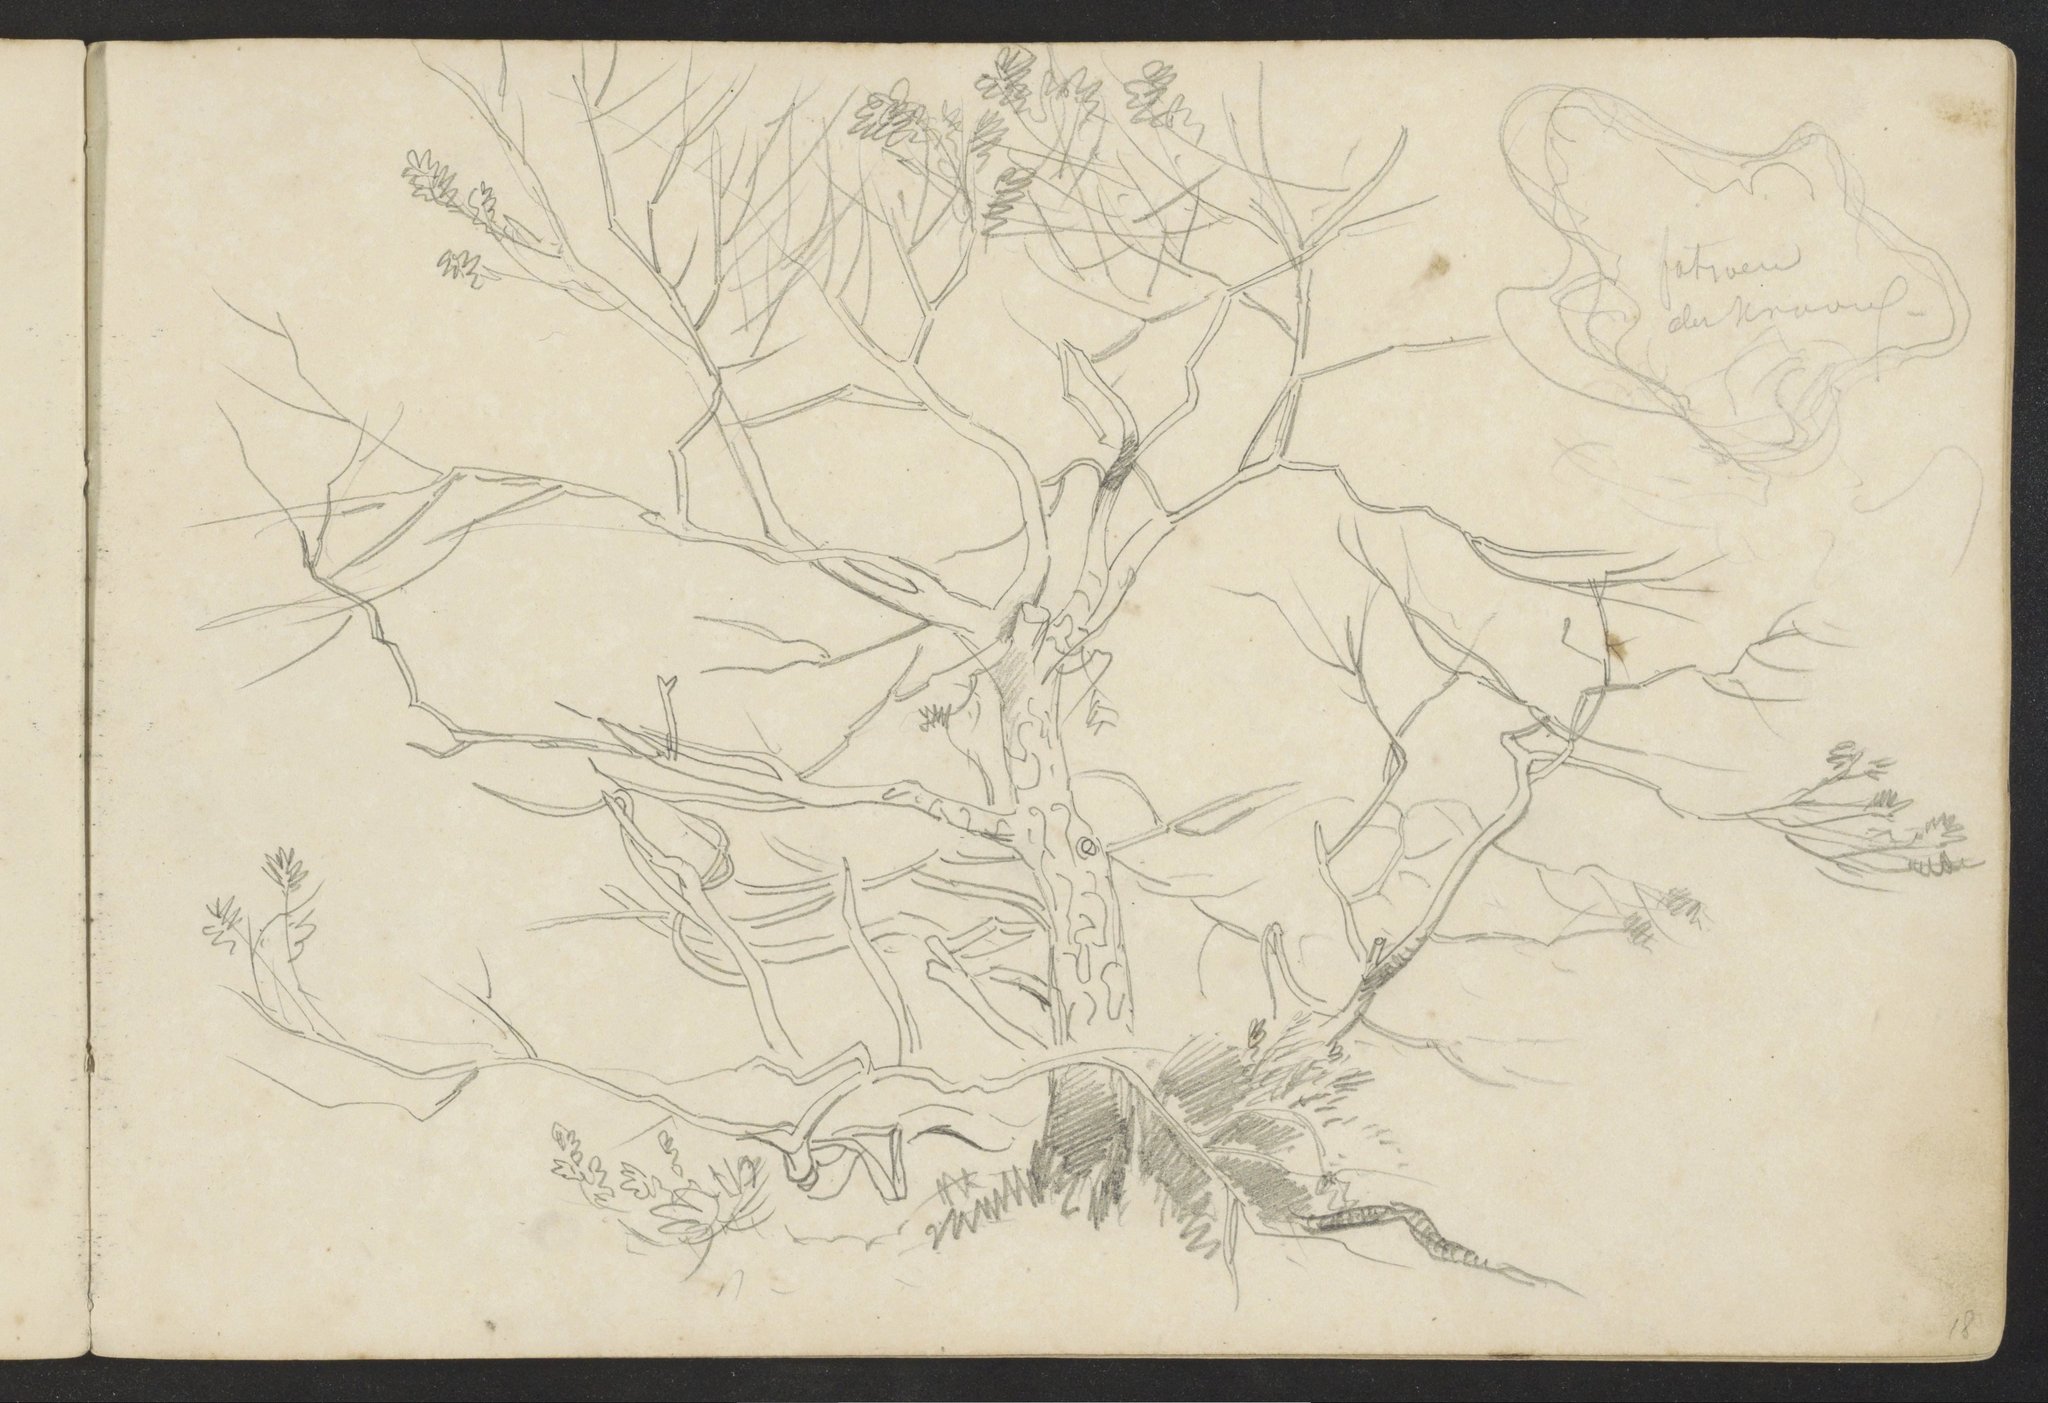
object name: sketchbook leaf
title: Boom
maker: johannes tavenraat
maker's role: draughtsman, painter, print maker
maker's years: 1809-1881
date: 1842-1868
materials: paper, pencil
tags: trees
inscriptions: annotation: ‘fatsoen/ der Kr[...]’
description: Blad 18 recto uit een schetsboek met 45 bladen.